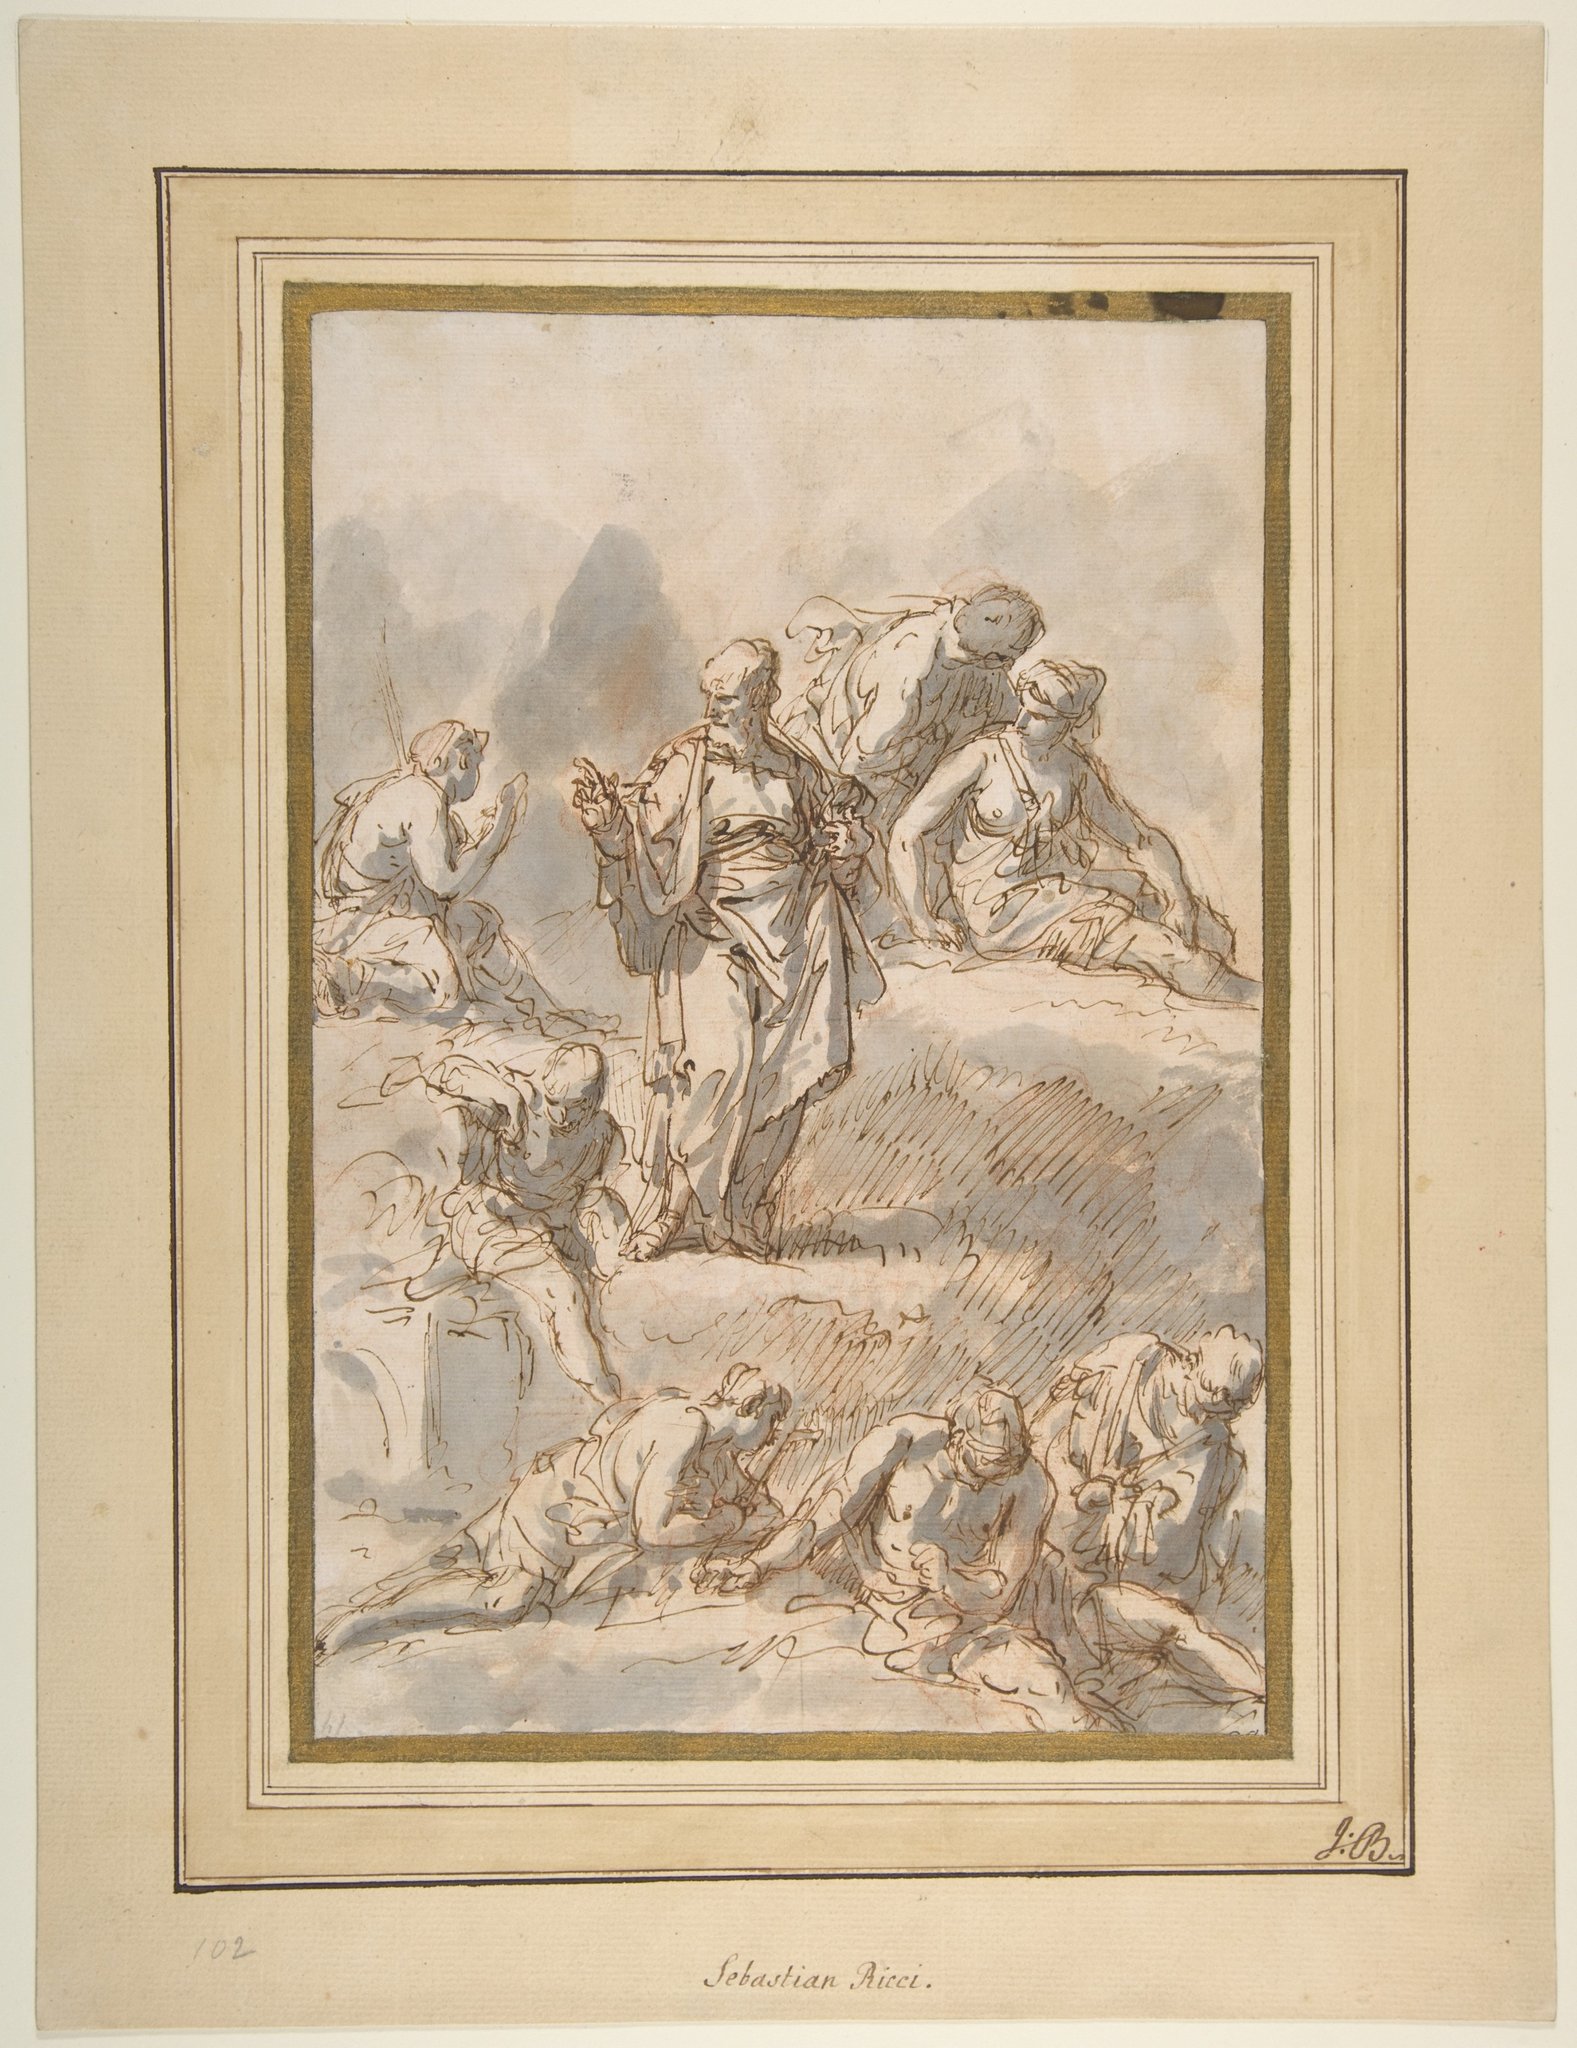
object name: drawing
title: Figure Studies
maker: sebastiano ricci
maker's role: artist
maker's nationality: italian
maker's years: 1659-1734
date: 1659-1734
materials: chalk, ink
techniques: brush, pen, wash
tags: men,women